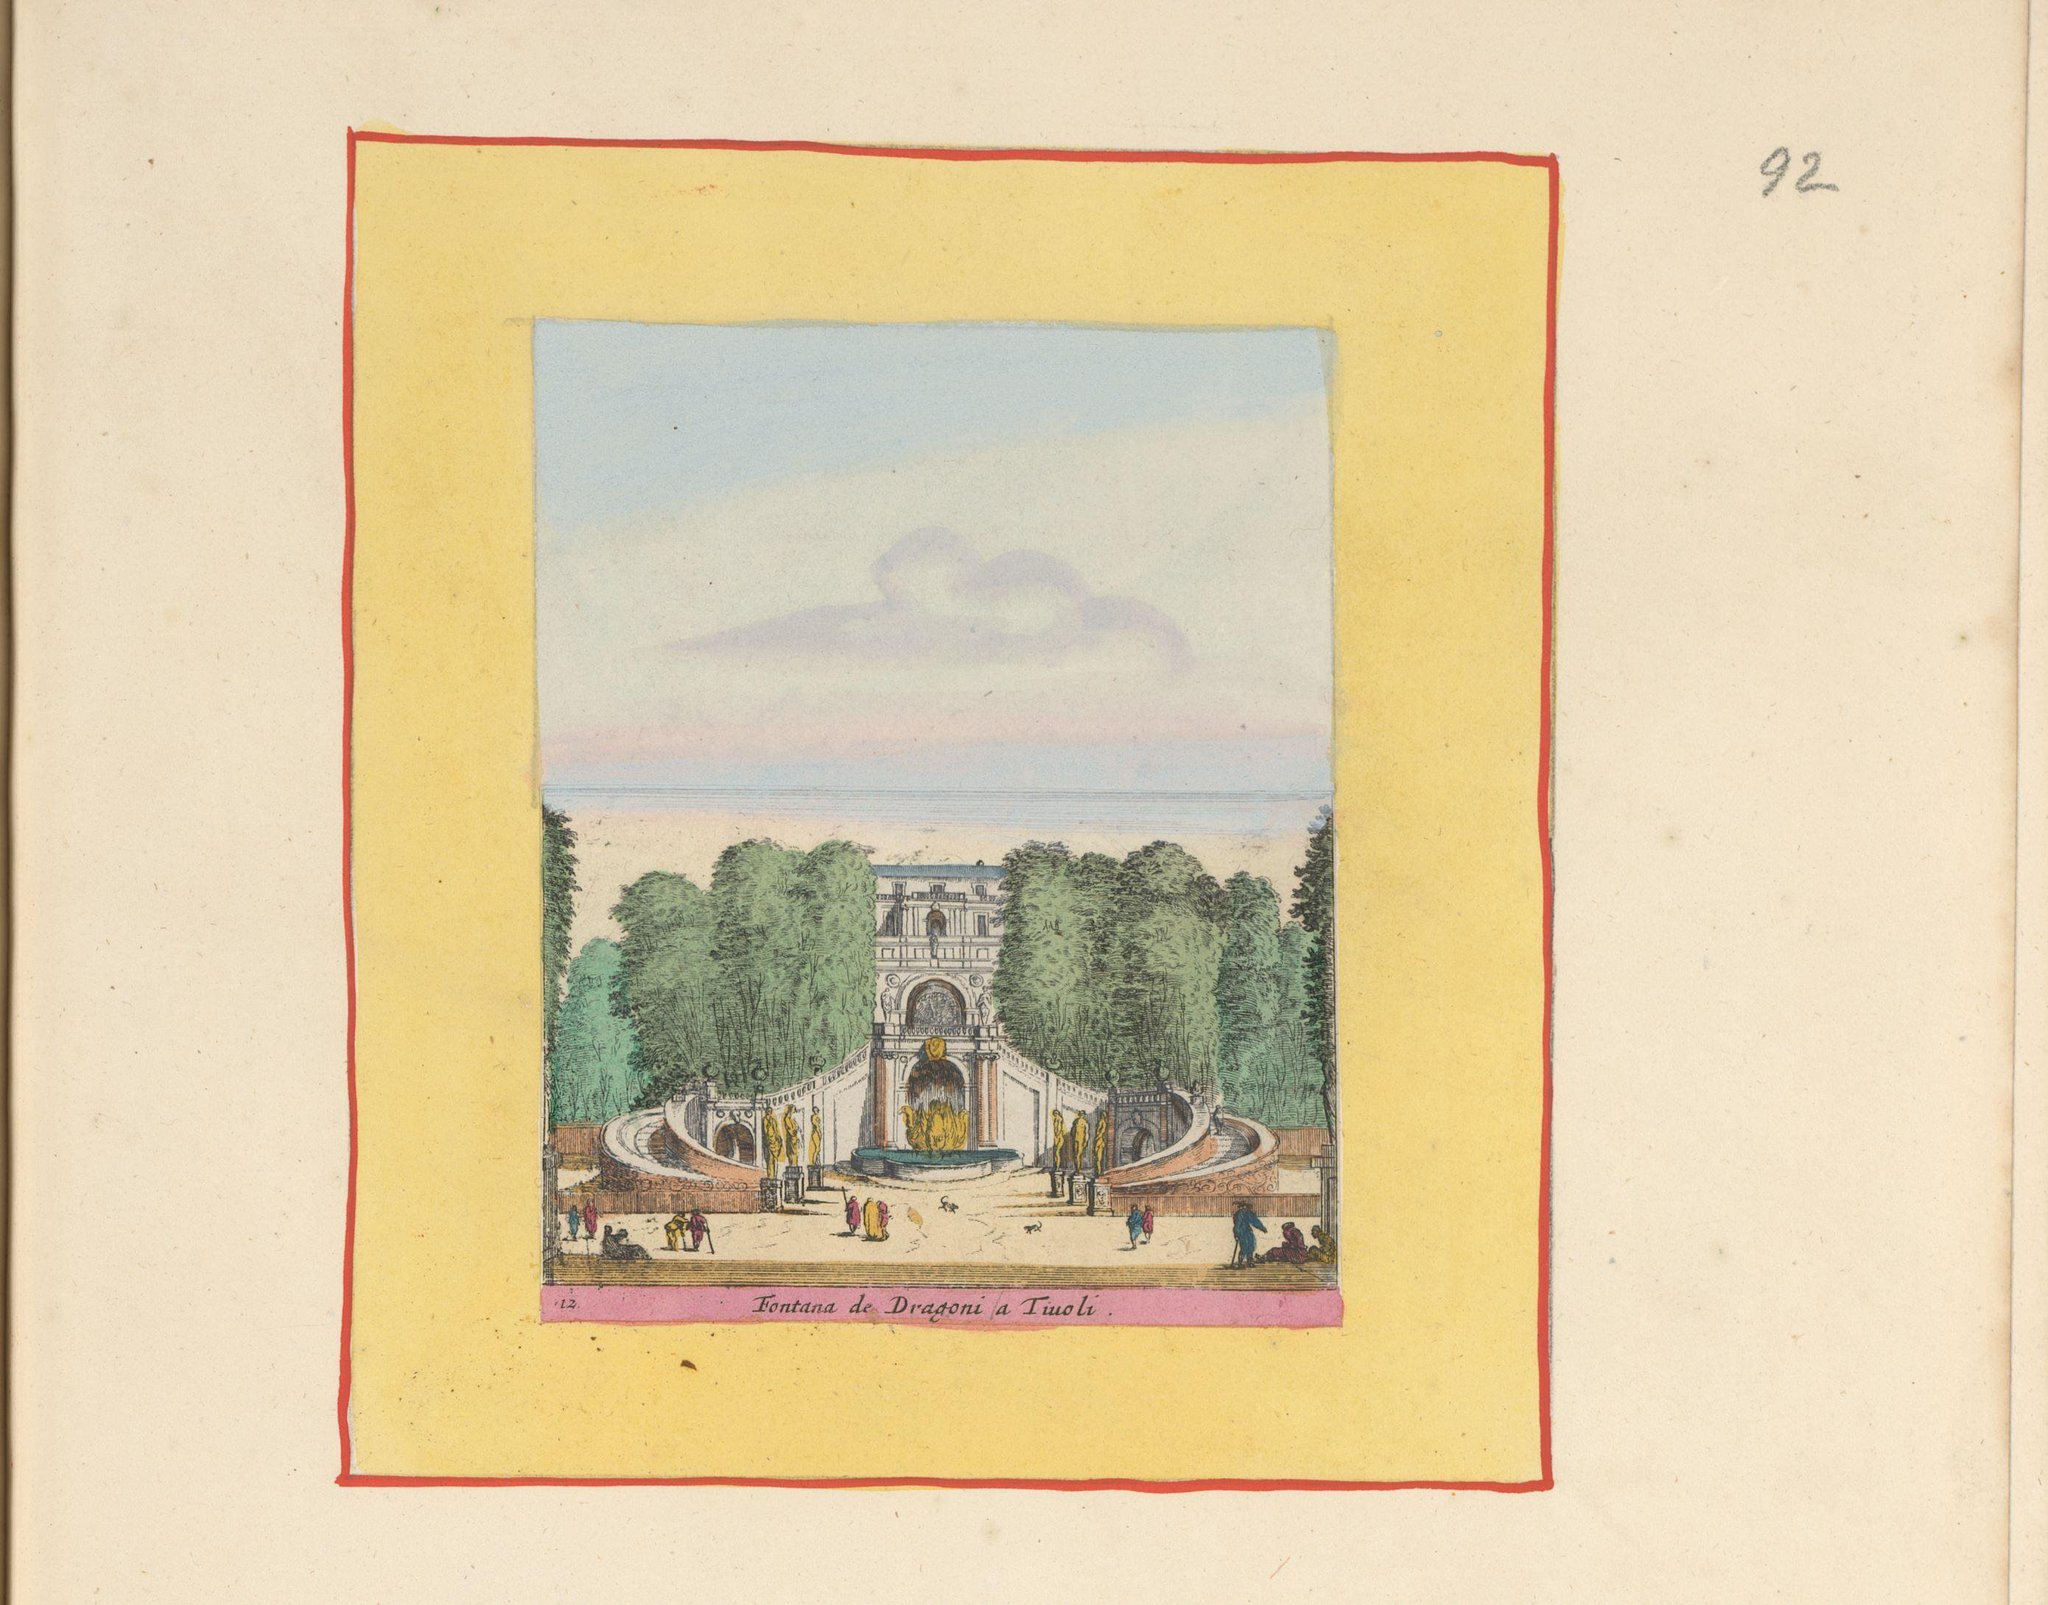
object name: album leaf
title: Fontana de Dragoni a Tivoli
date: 1631-1691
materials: paper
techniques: colour, etching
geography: france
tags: city-view, and landscape with man-made constructions, landscape with ruins, temple, shrine ~ roman religion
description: De Drakenfontein in Villa d'Este te Tivoli. Titel in het Italiaans in ondermarge. Prent maakt deel uit van een album.